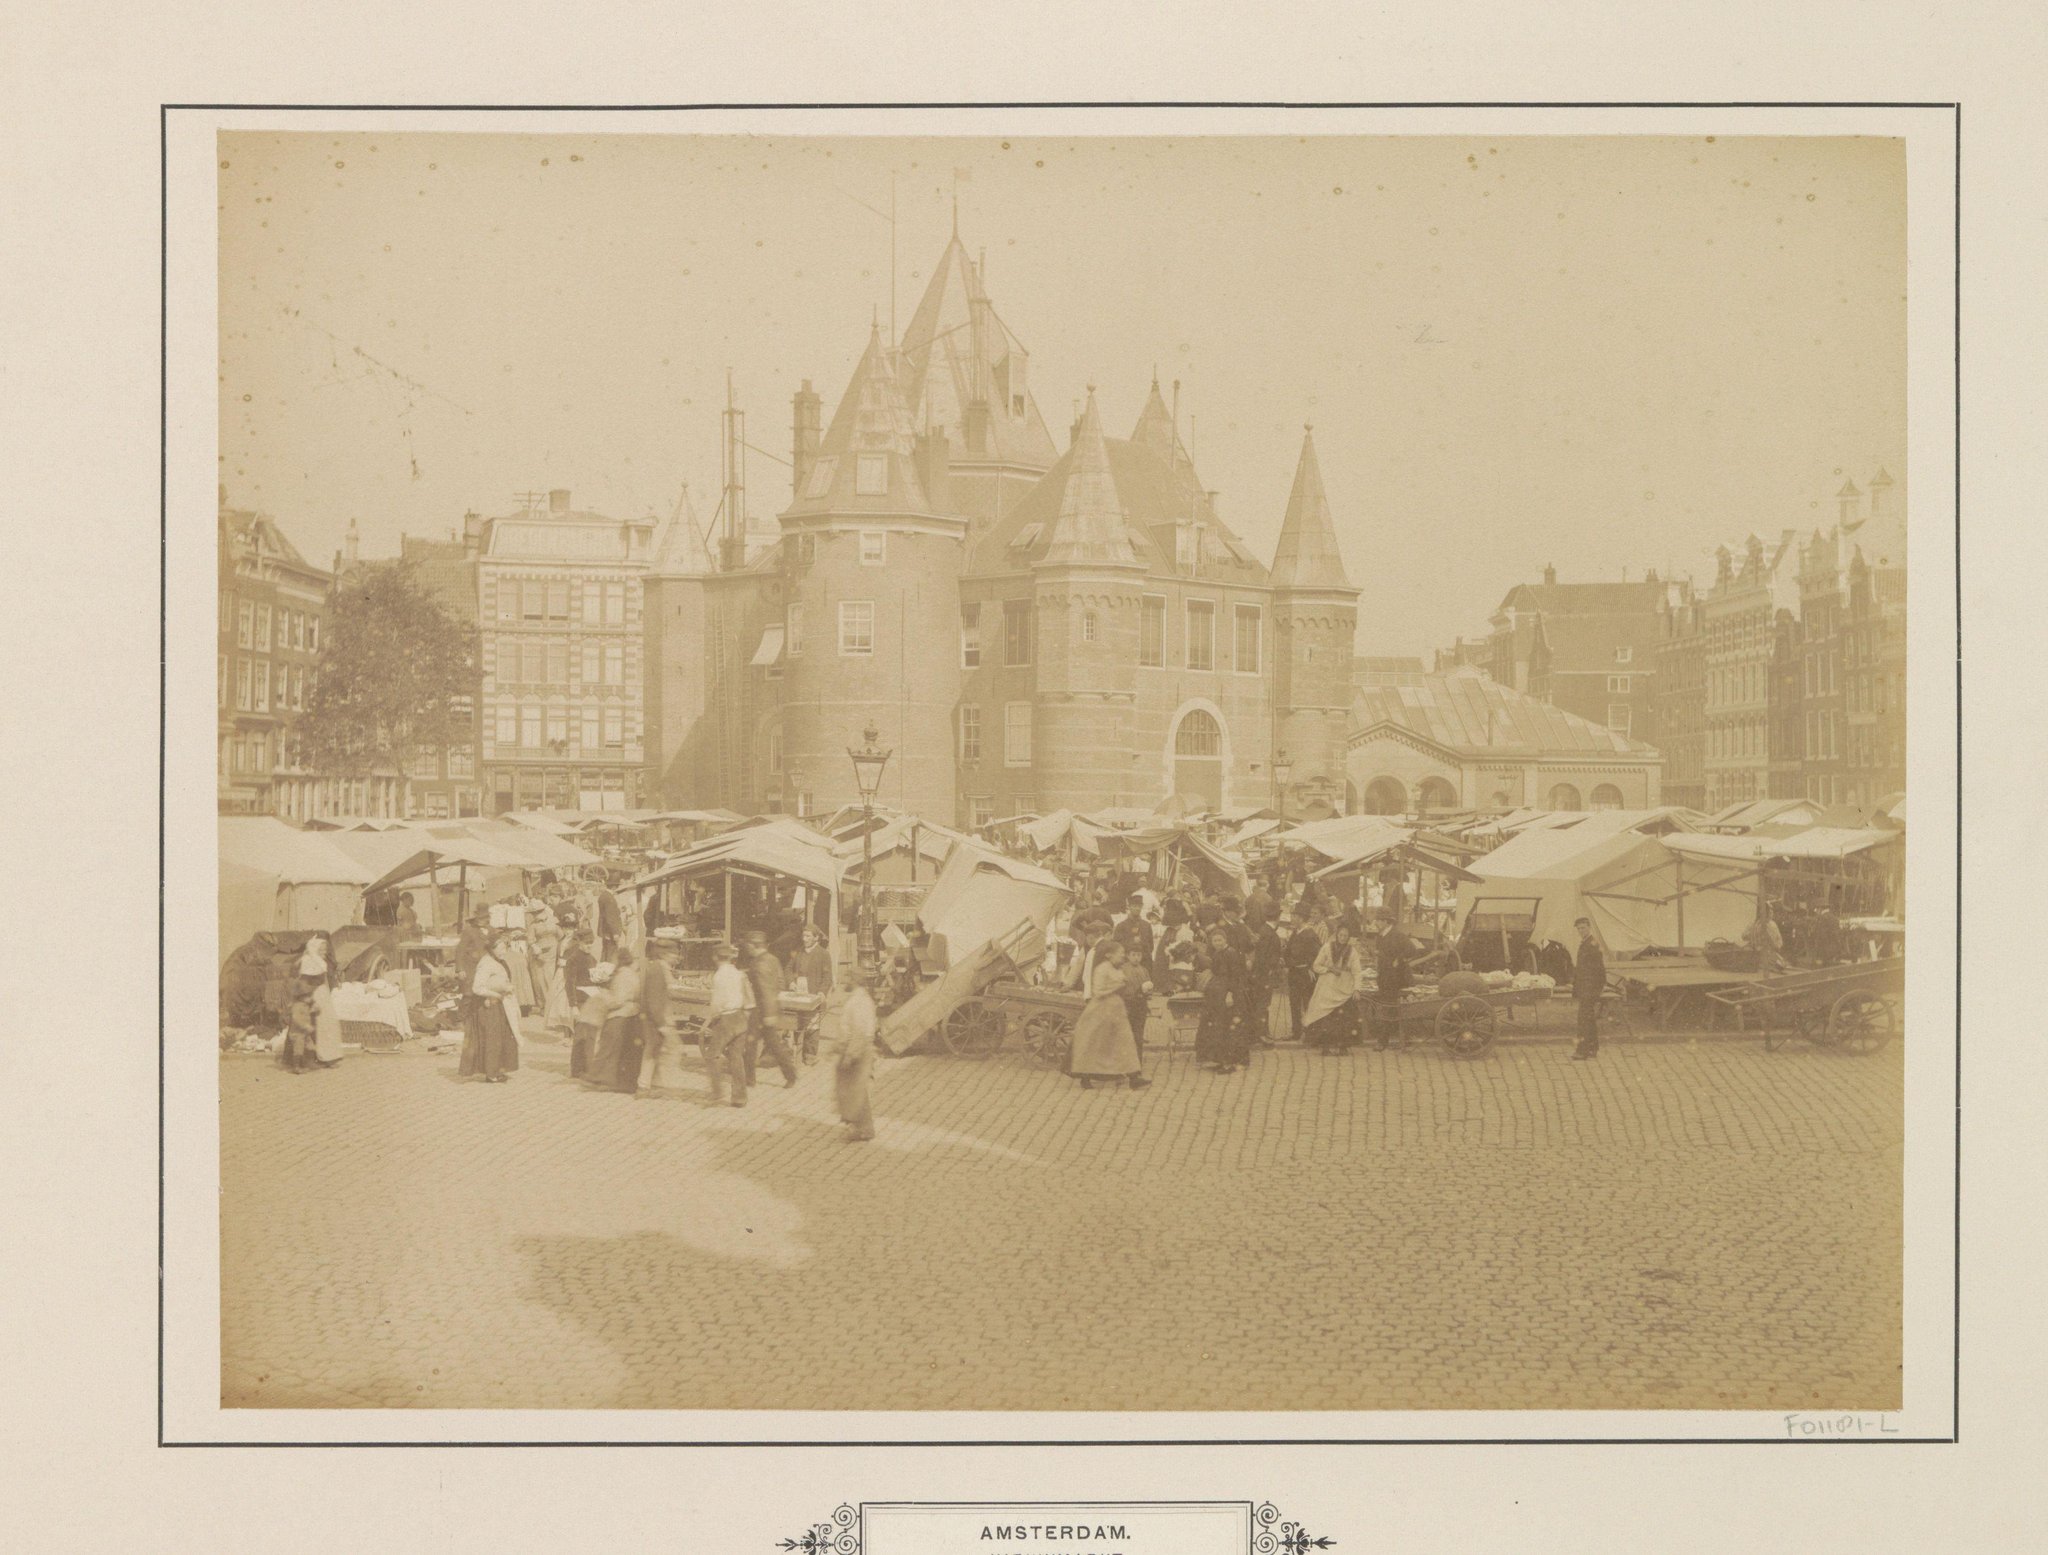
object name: photograph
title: Amsterdam, Nieuwmarkt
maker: Anonymous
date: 1880-1895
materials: photographic support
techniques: albumen print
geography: amsterdam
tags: market, weigh-house, square, place, circus, etc. (+ city(-scape) with figures, staffage)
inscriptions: inscription: ‘Hendrik Groote. 43. Kalverstraat 43. Eastman Kodak Agency Darkroom at disposal.’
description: Onderdeel van Fotoalbum met opnames van het centrum van Amsterdam en reclameteksten voor winkels en bedrijven.